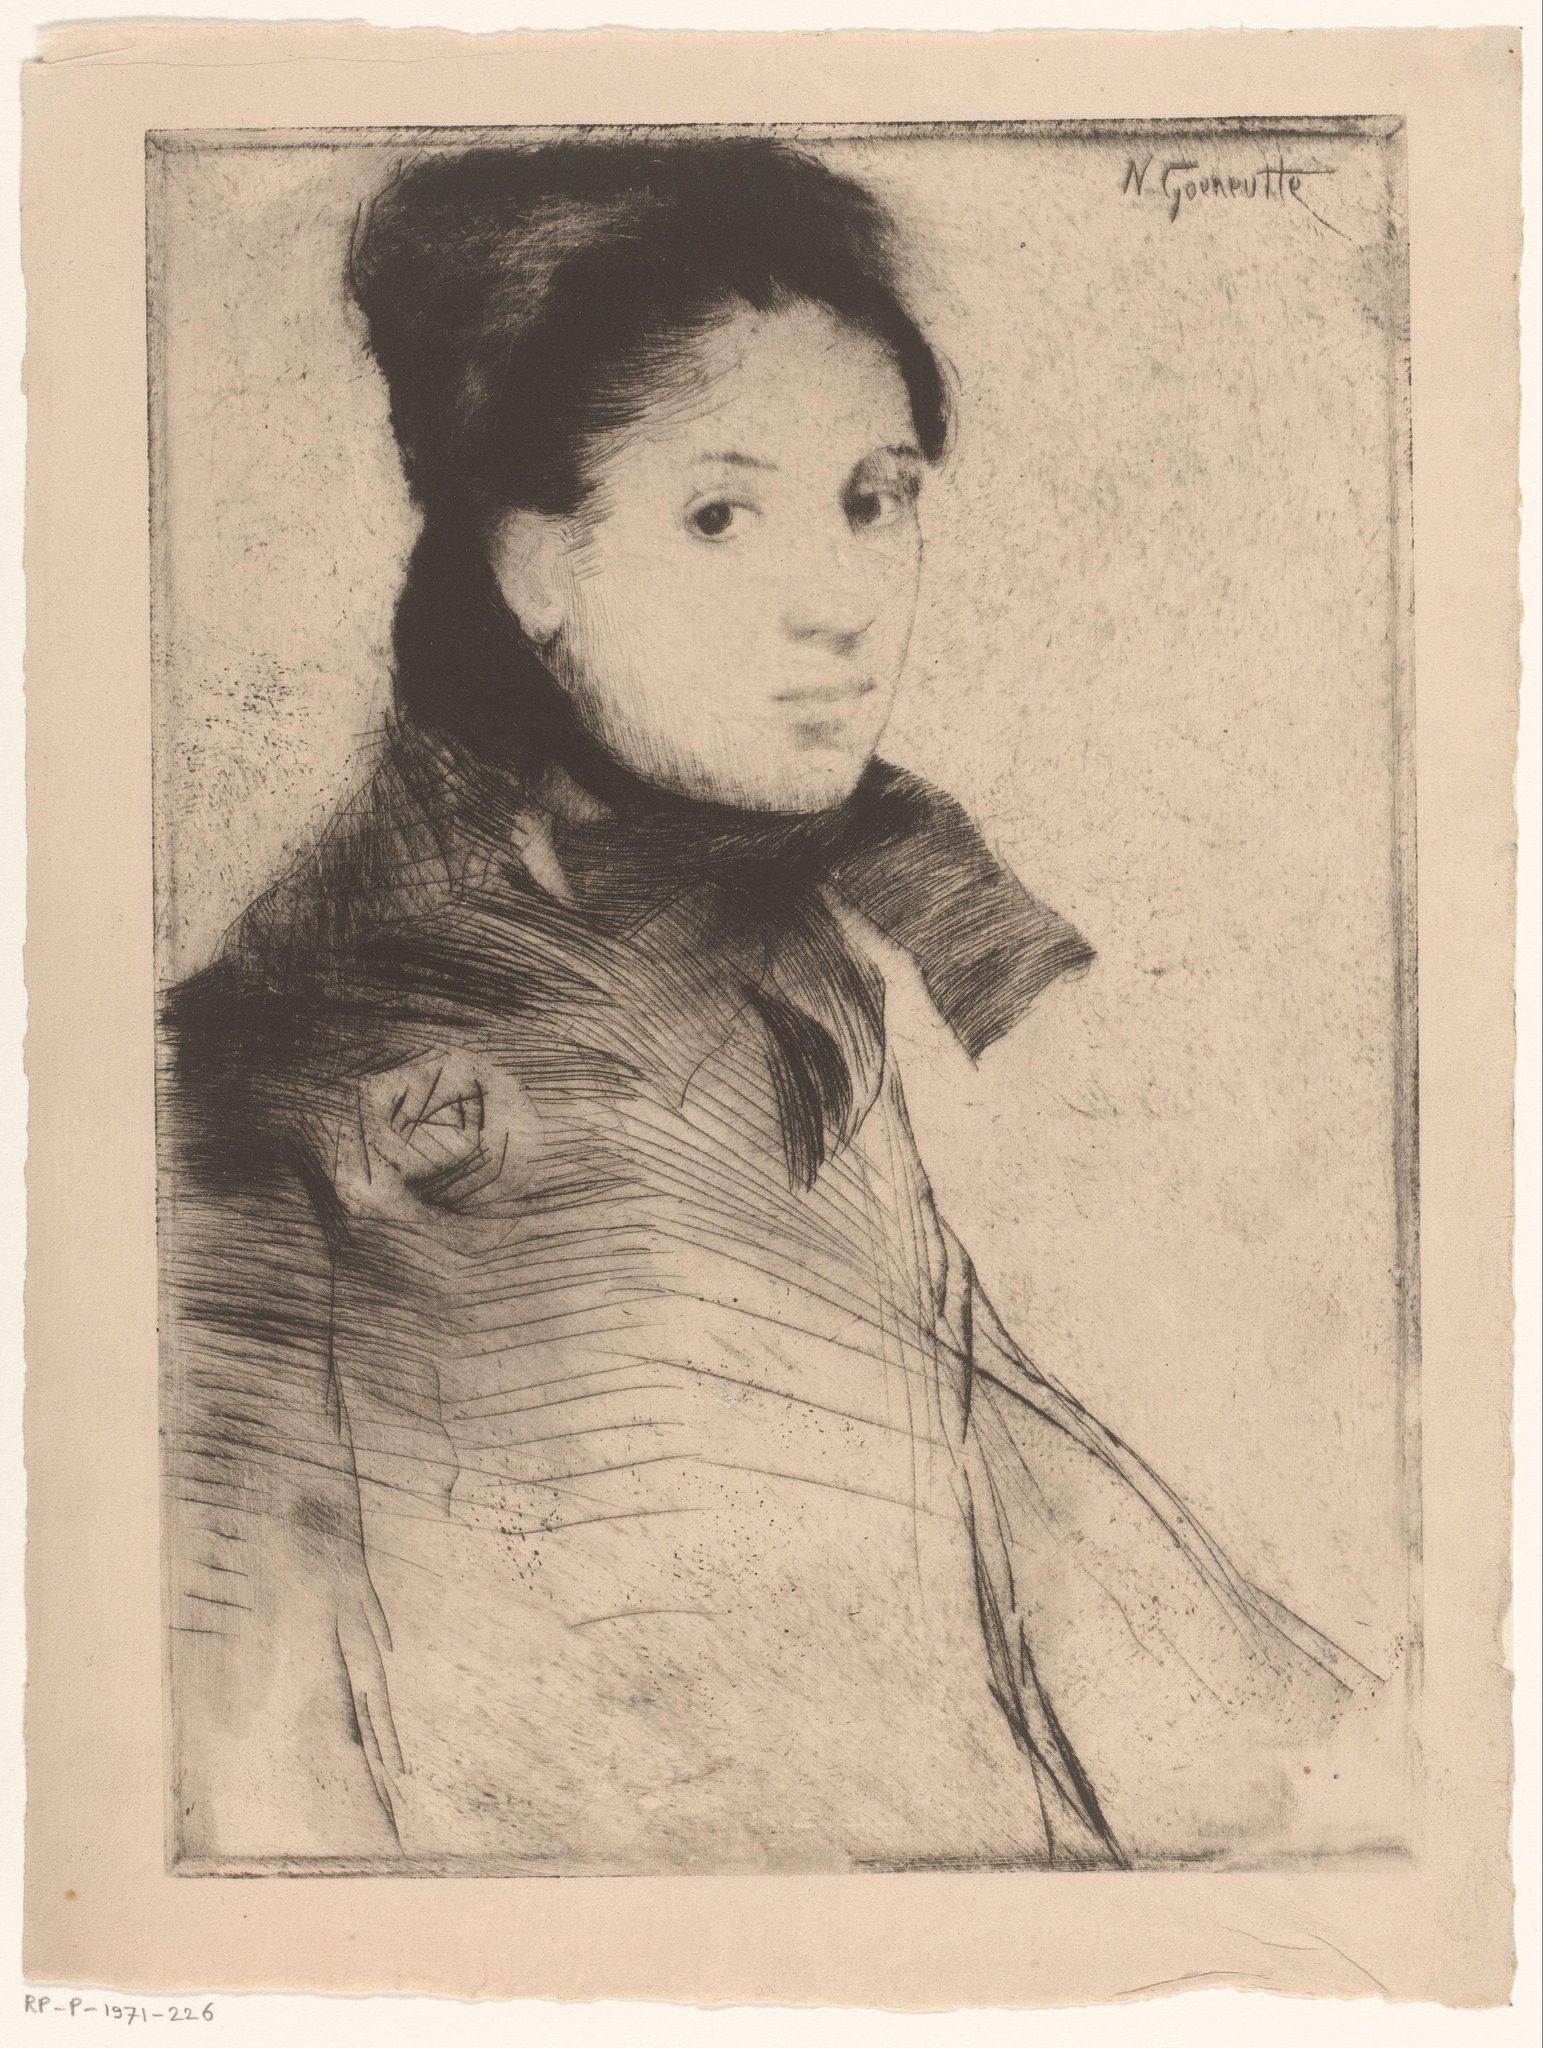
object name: print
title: Portret van een onbekende jonge vrouw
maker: norbert goeneutte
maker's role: draughtsman, painter, print maker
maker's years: 1854-1894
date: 1888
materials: paper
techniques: drypoint, intaglio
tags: historical persons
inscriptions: collector's mark: Lugt 2228, collector's mark: Lugt 2760